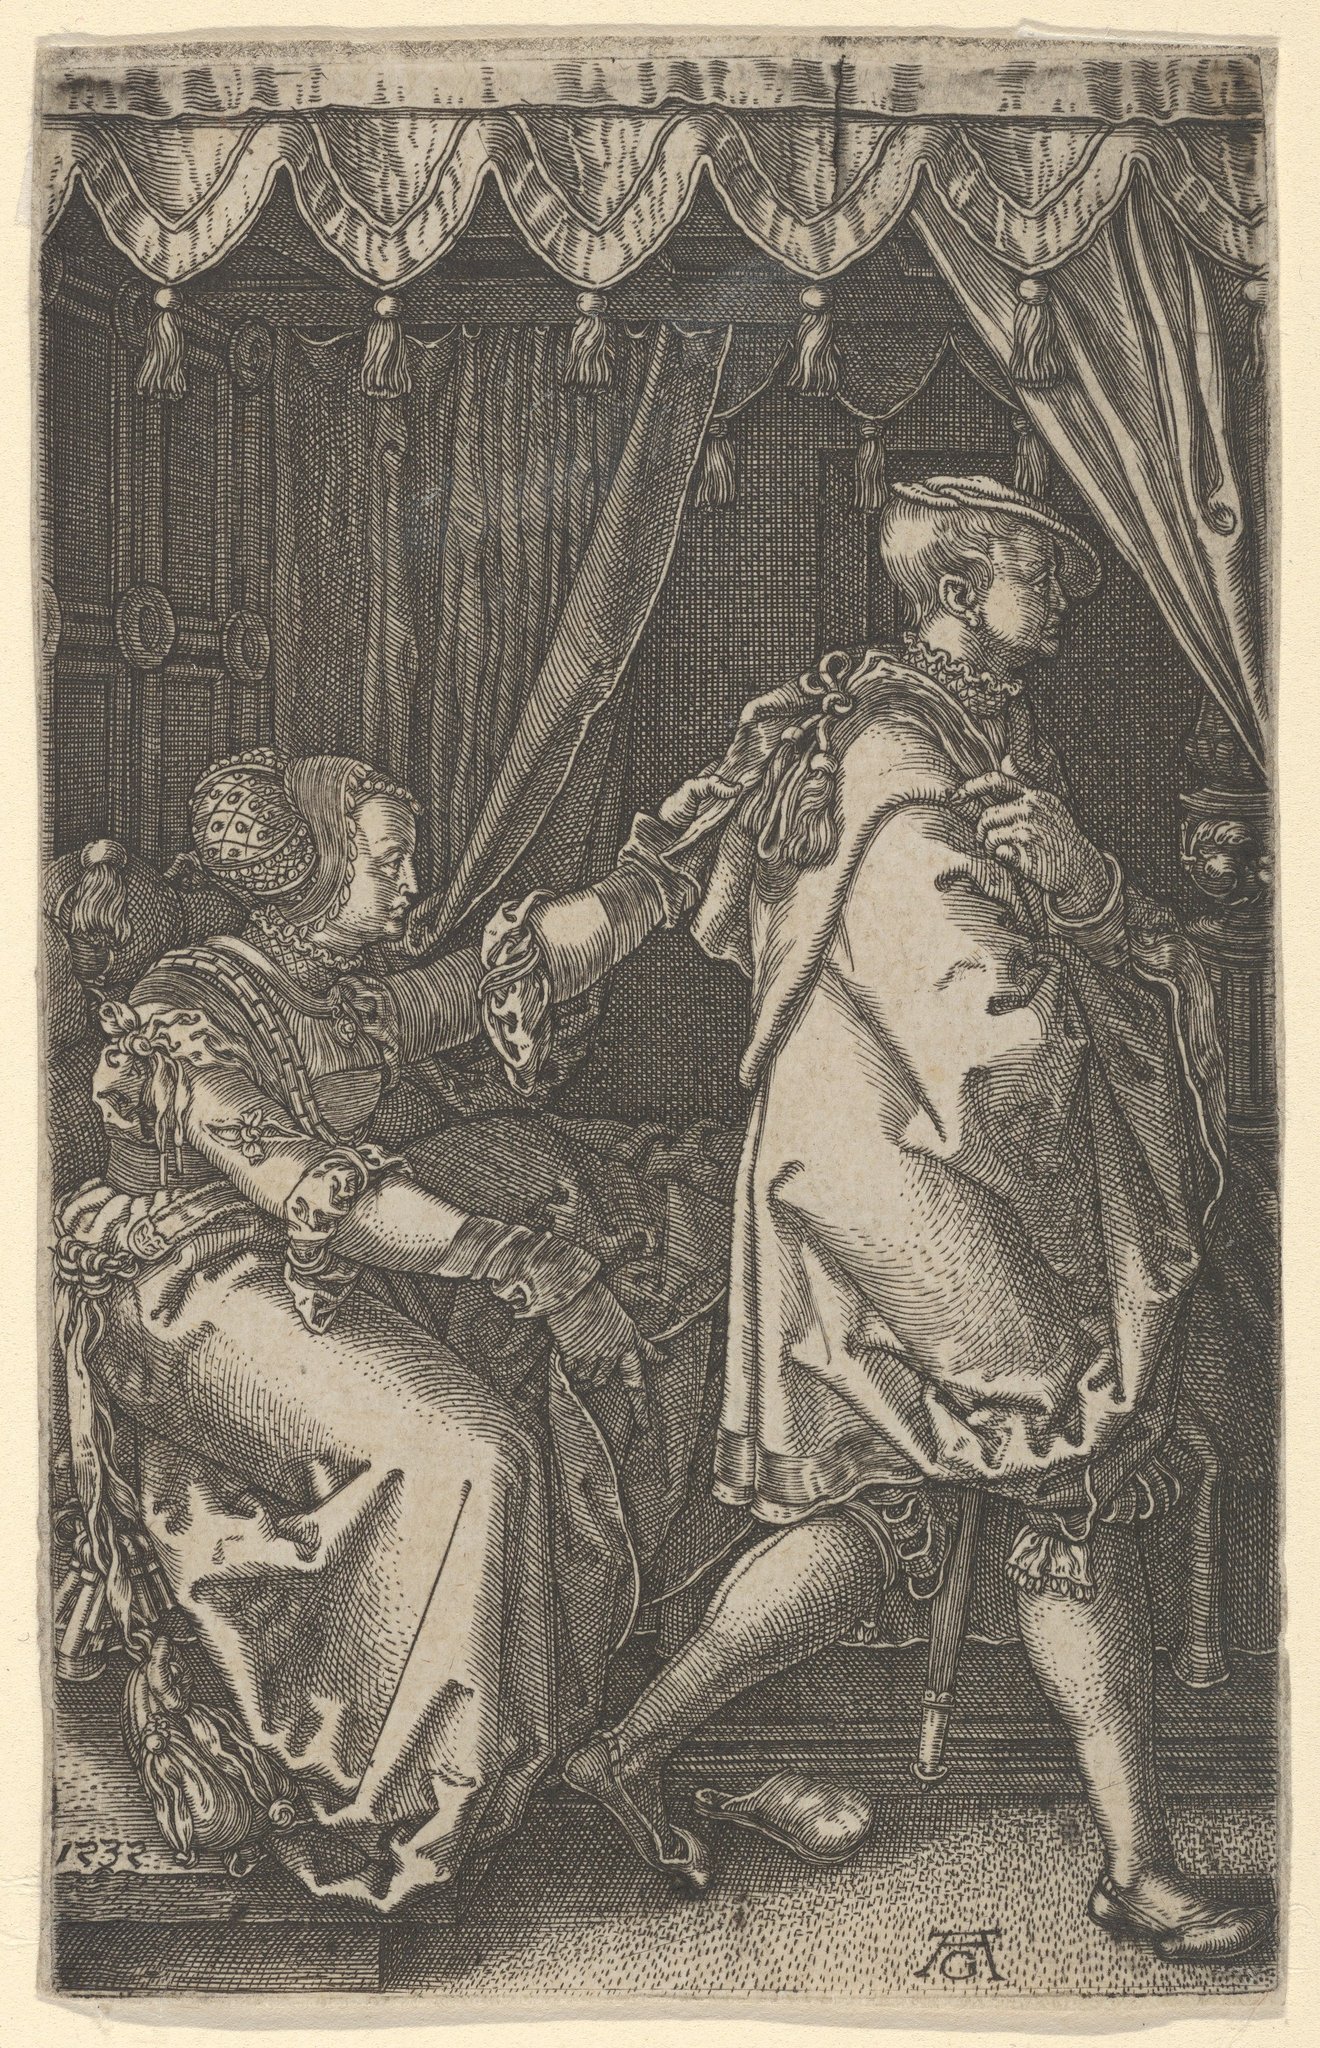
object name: print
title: Joseph and Potiphar's Wife, from "The Story of Joseph"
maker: heinrich aldegrever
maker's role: artist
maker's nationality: german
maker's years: 1502-1561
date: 1532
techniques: engraving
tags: swords,men,women